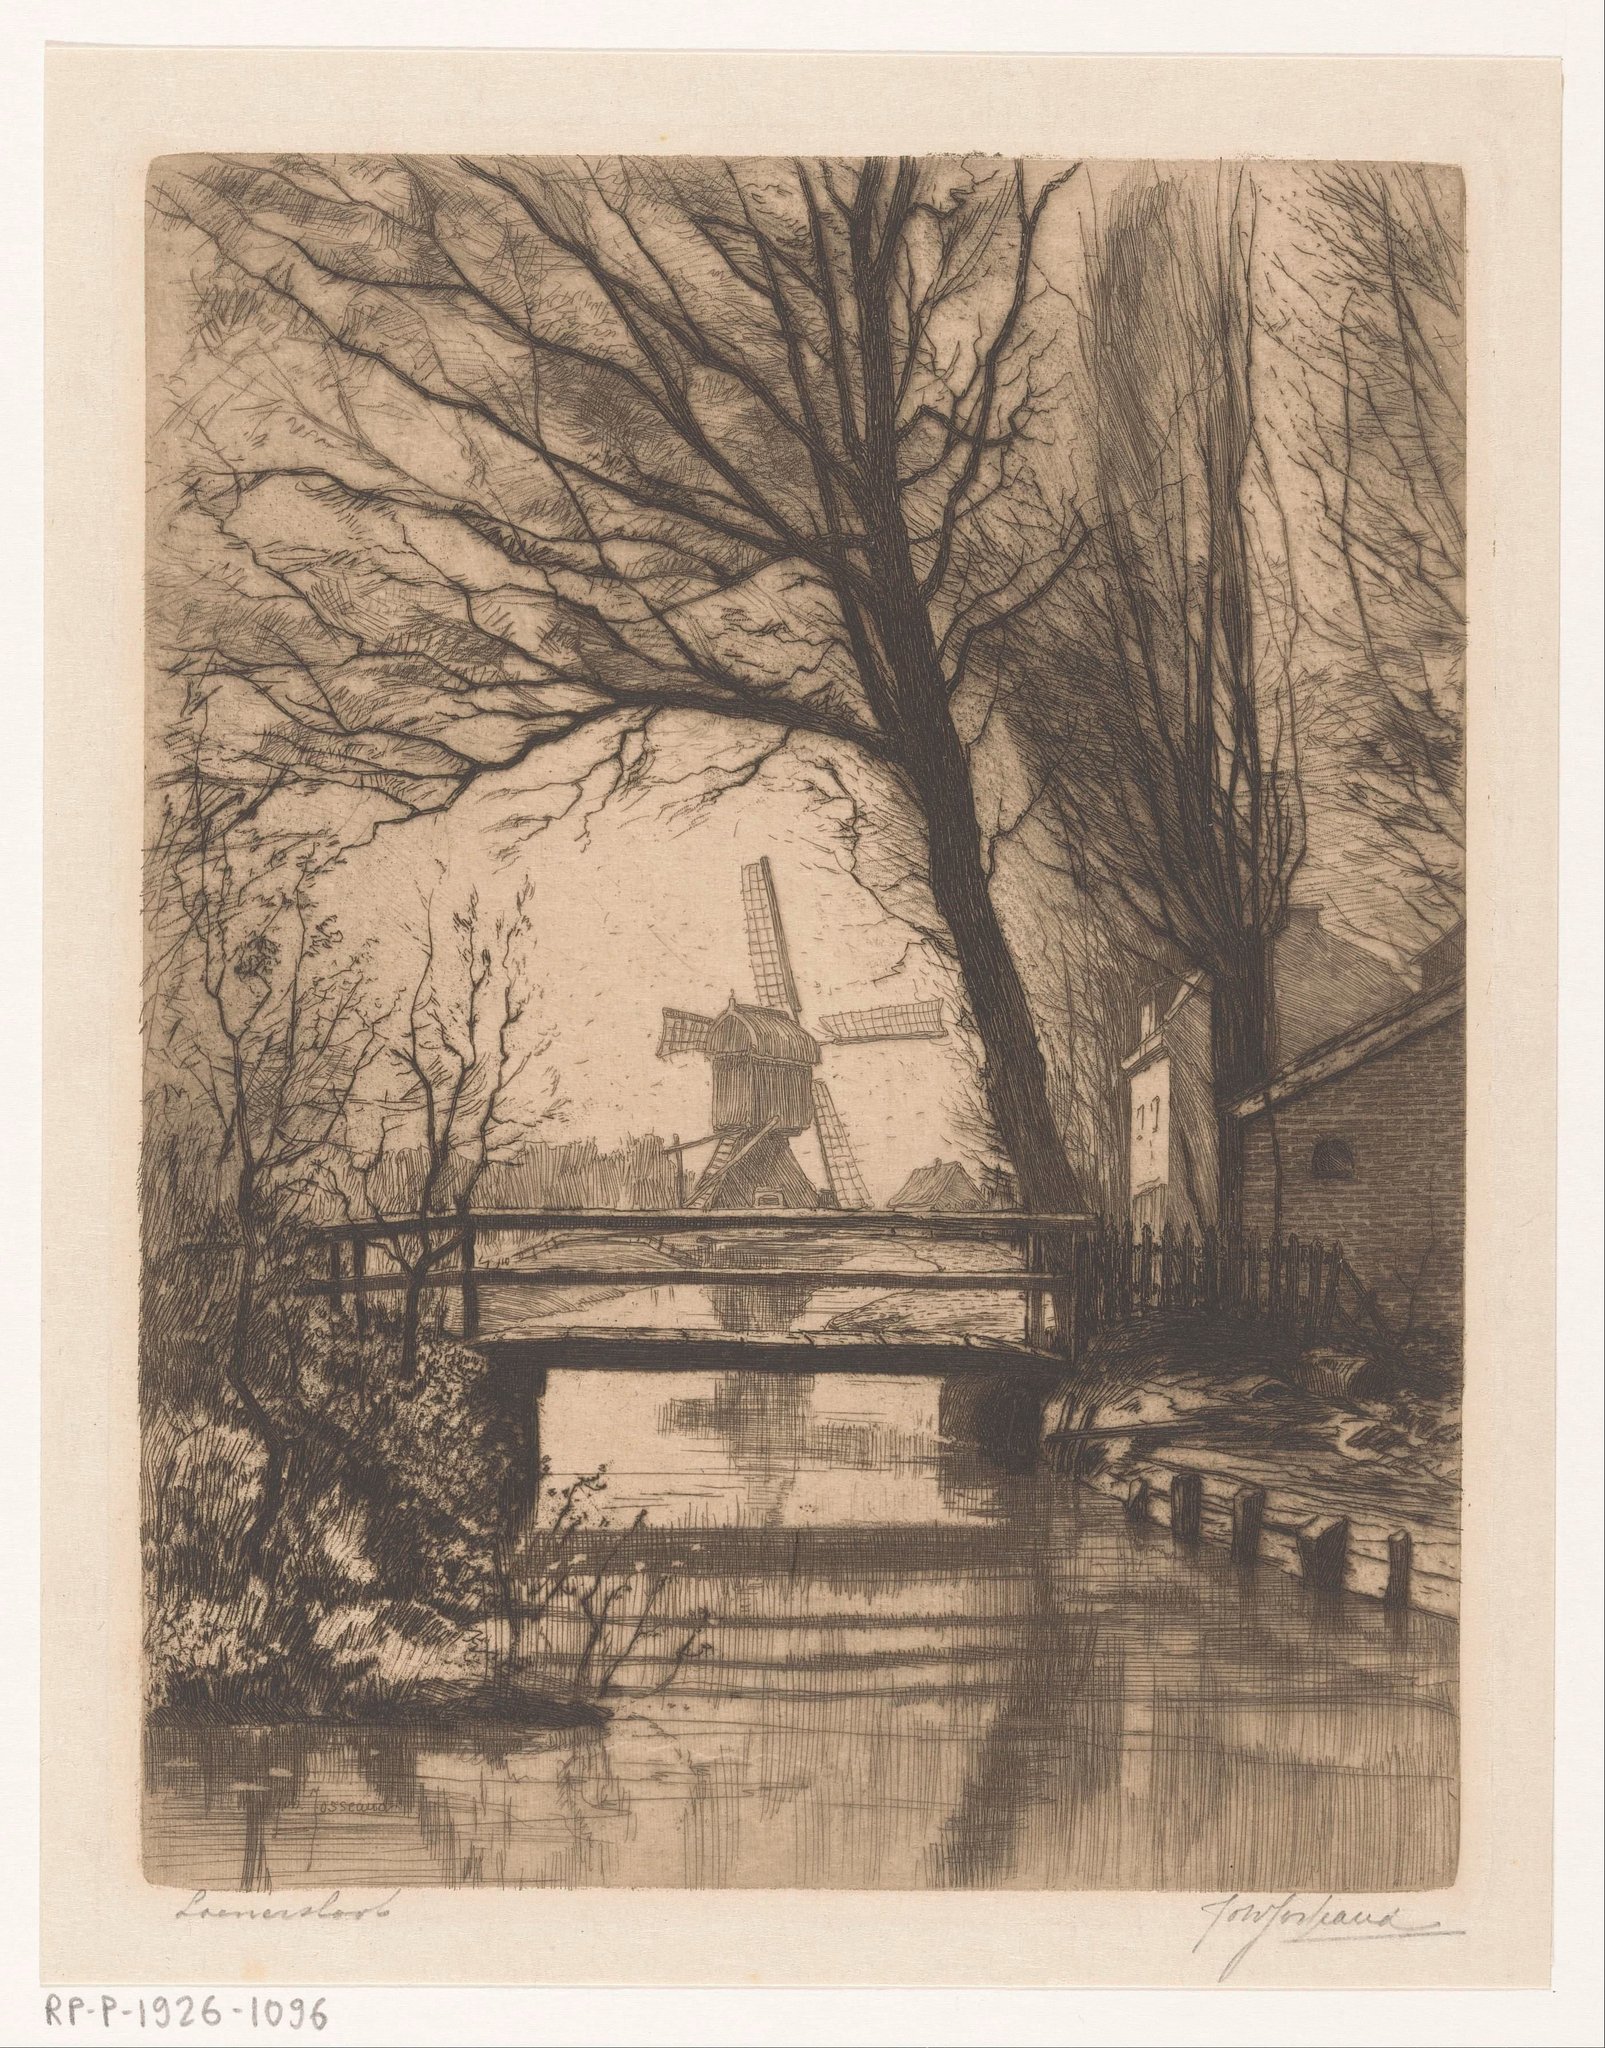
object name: print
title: Loenersloot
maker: johannes josseaud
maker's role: print maker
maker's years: 1880-1935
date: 1890-1926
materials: paper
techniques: etching, intaglio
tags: windmill in landscape, bridge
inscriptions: collector's mark: Lugt 2228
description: Een brug over de rivier de Angstel in Loenersloot. Op de achtergrond de Oukopermolen.